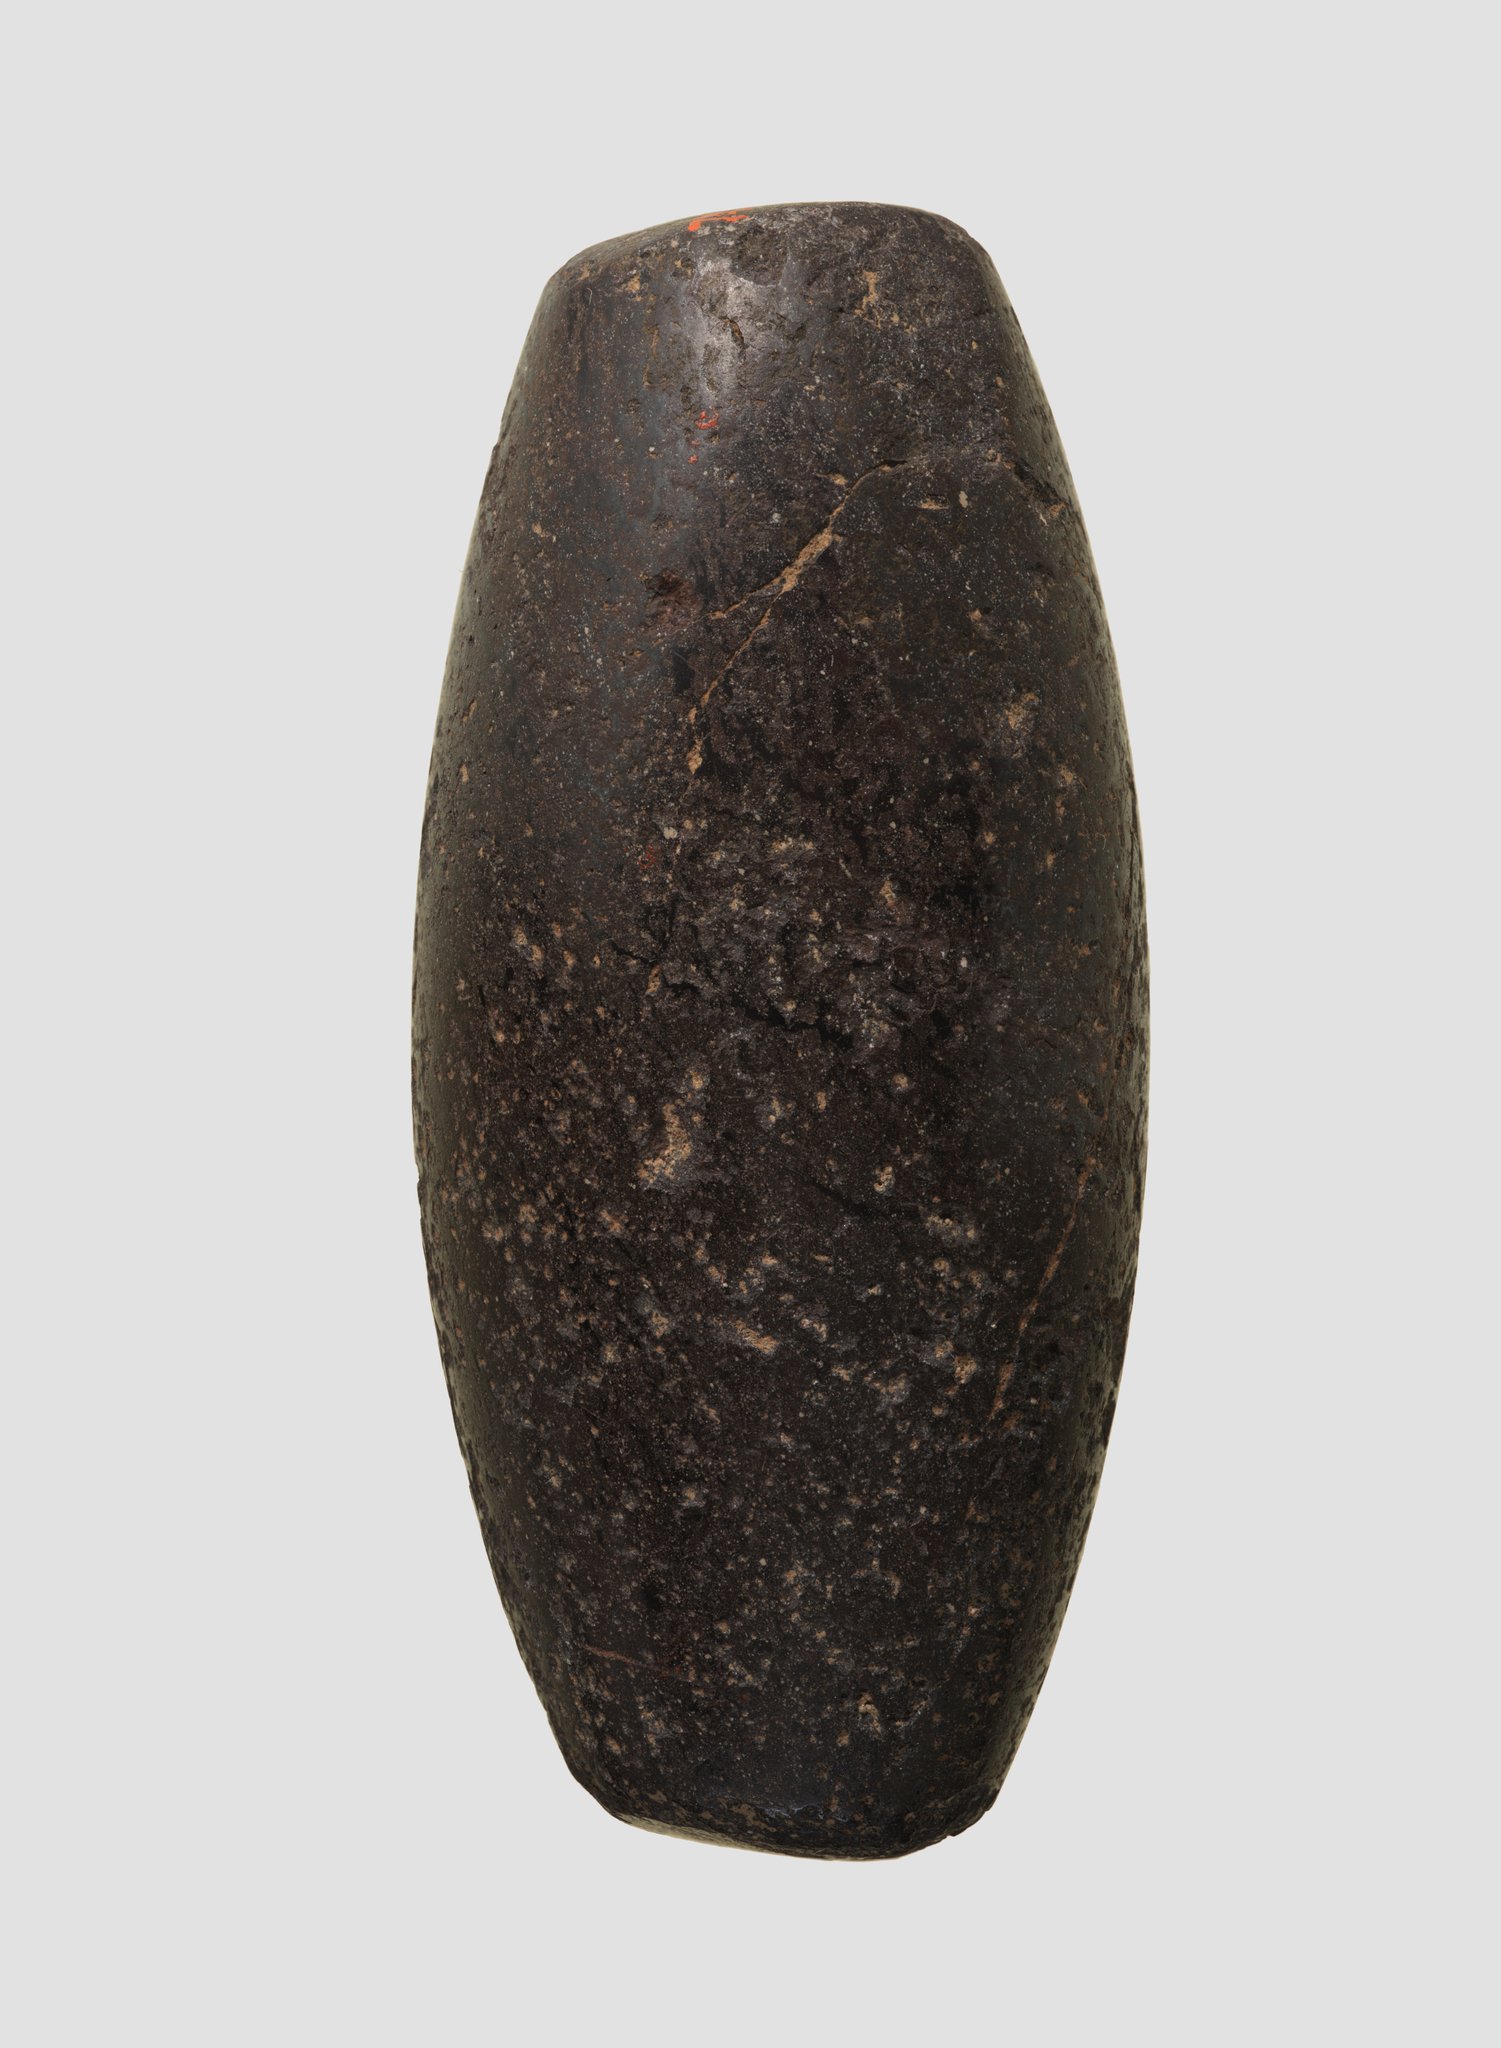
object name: weight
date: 3000-1 BCE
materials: mineral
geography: cyprus or western asia